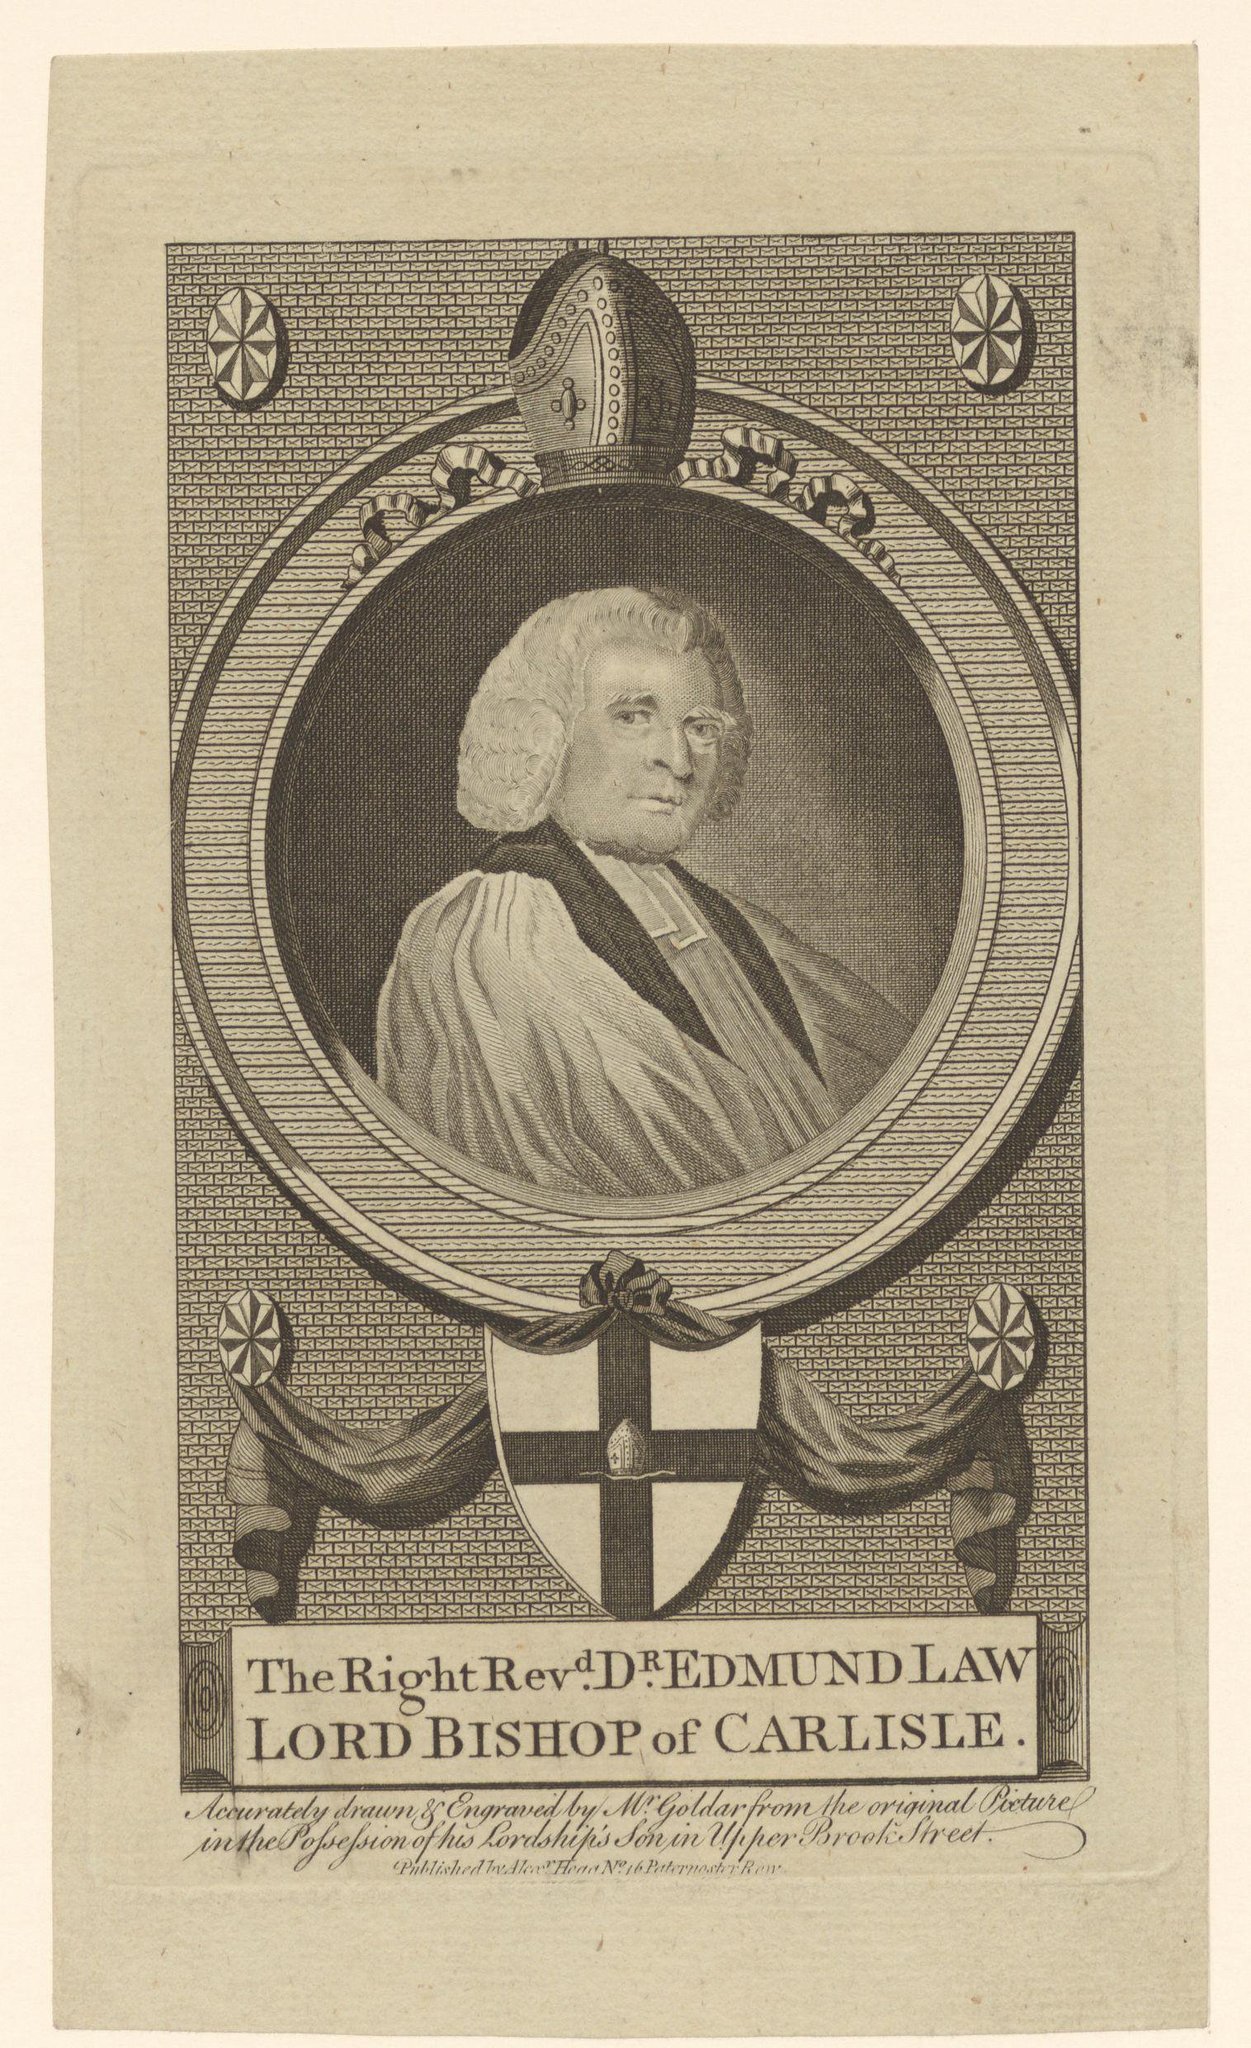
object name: print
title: Portret van Edmund Law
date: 1788-1795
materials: paper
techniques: engraving, etching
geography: london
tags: archbishop, bishop, etc. (roman catholic), historical persons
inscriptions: collector's mark: Lugt 2228